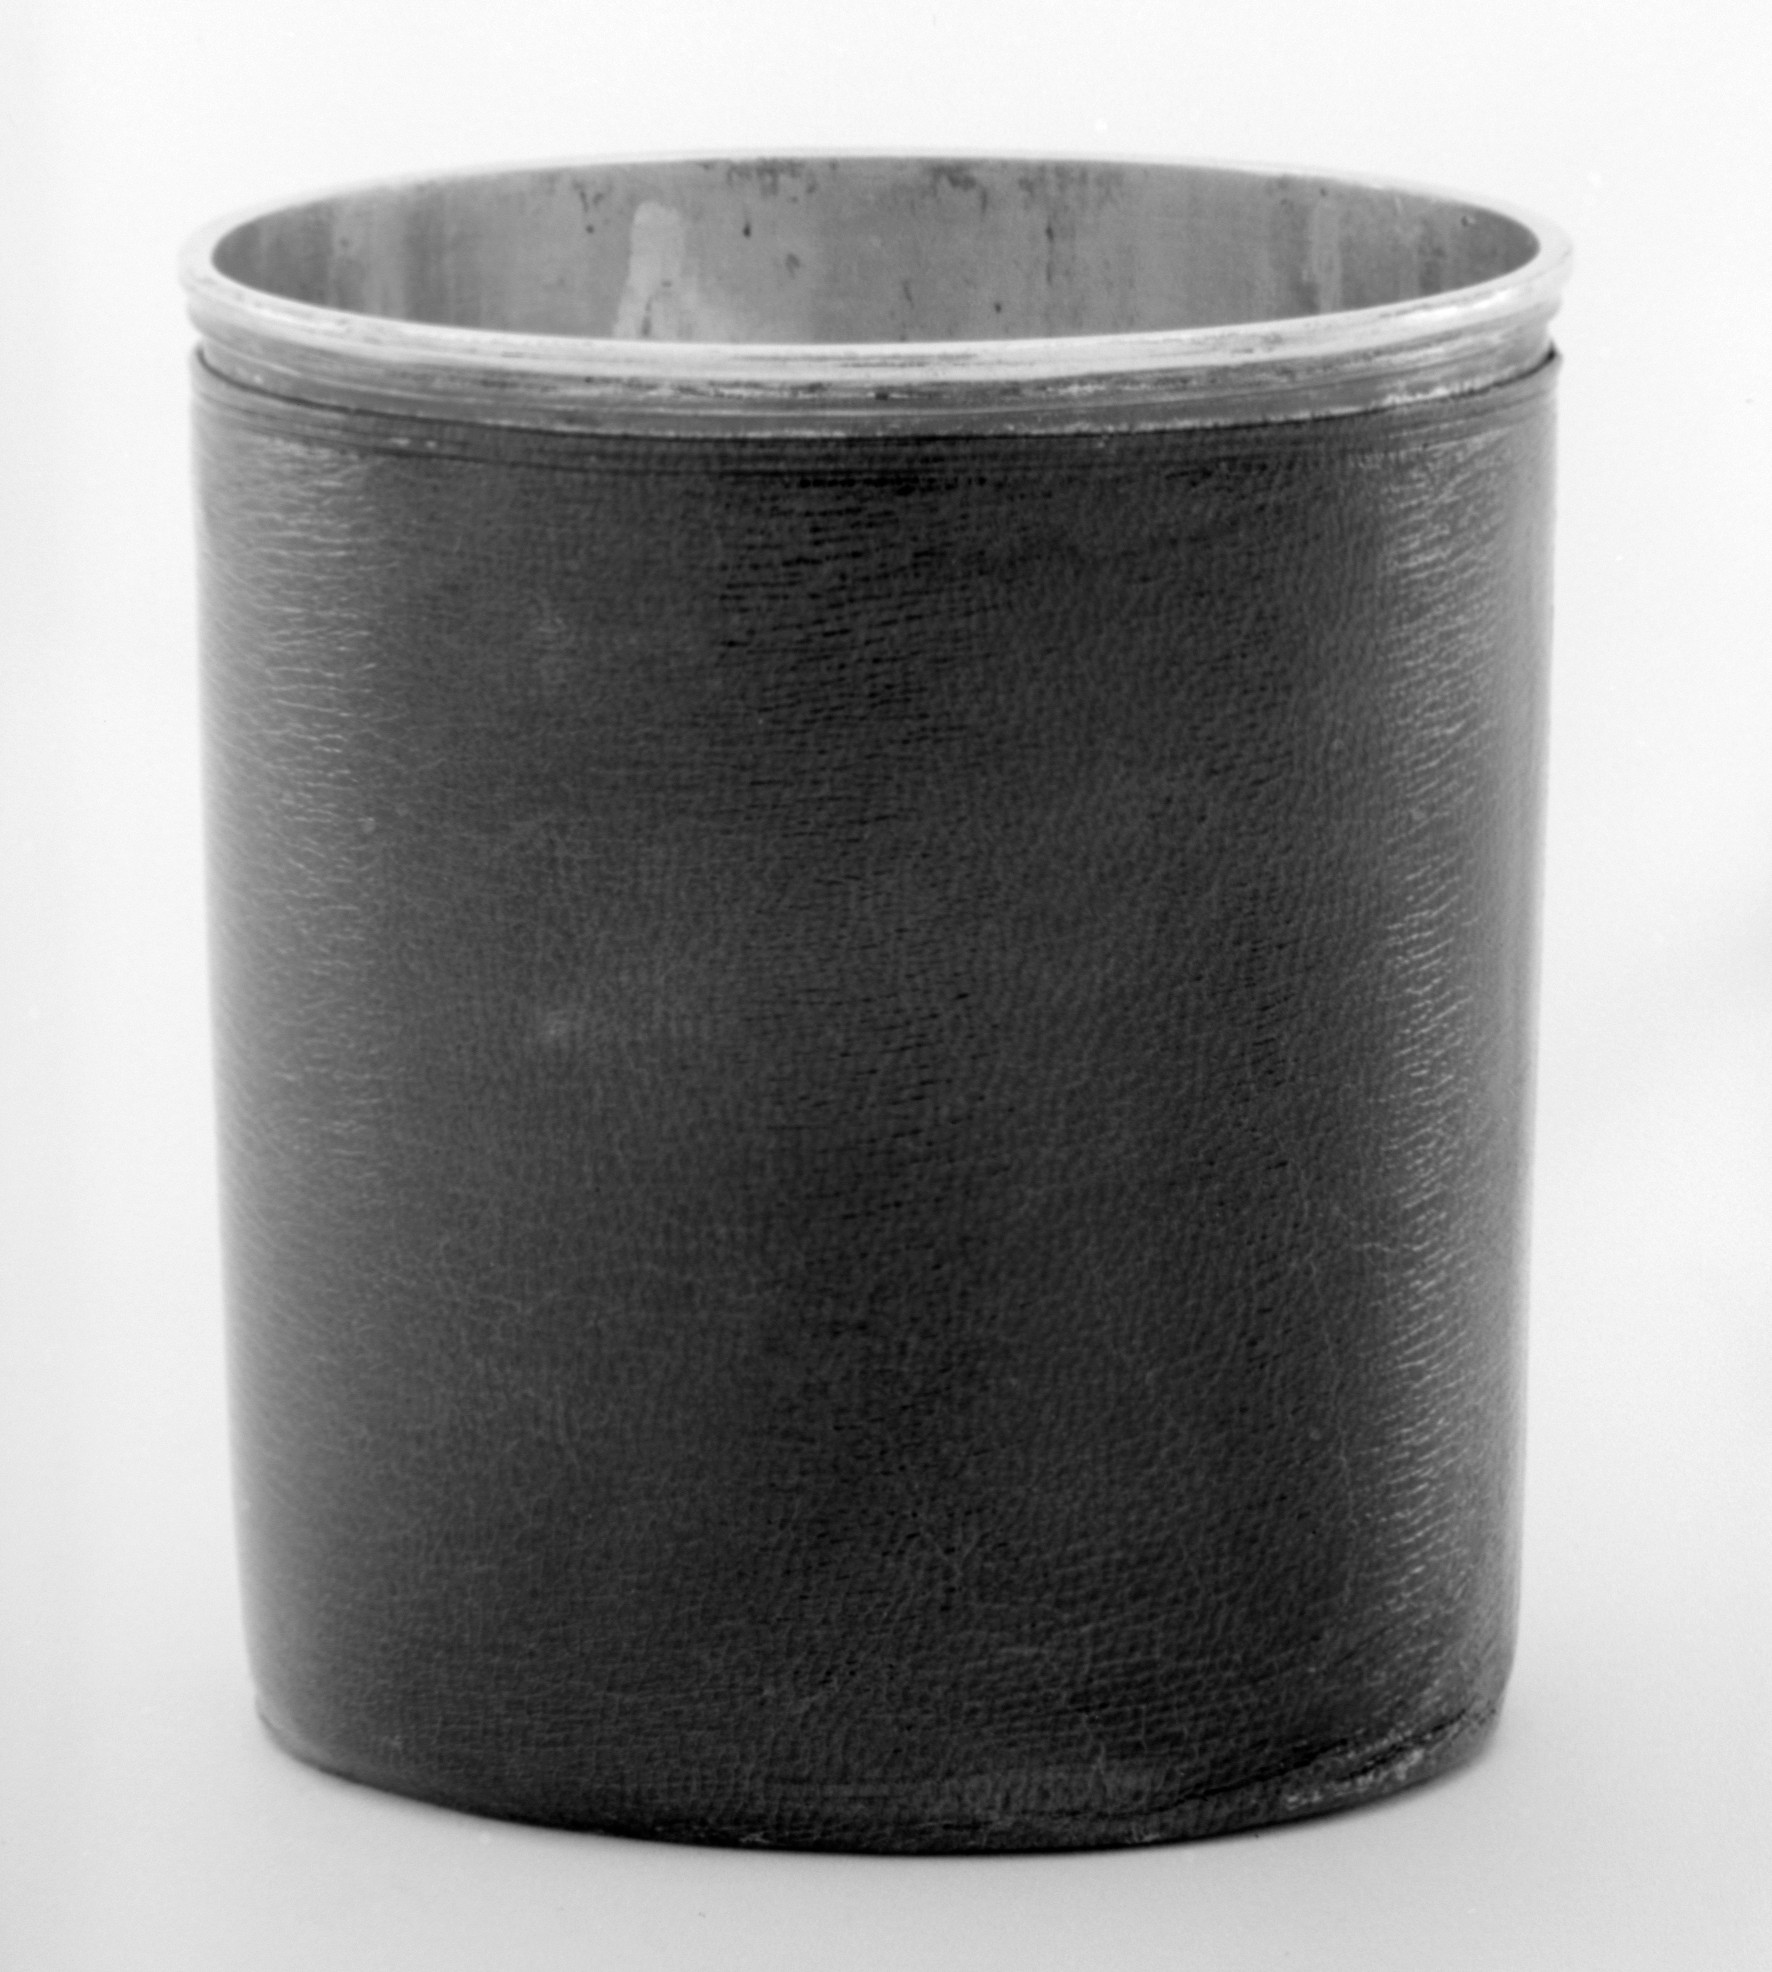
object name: beaker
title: Beaker (part of a set)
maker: johann bernhard hertz (hentz)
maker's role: maker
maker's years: 1834-1855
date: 1848-1849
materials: leather, silver